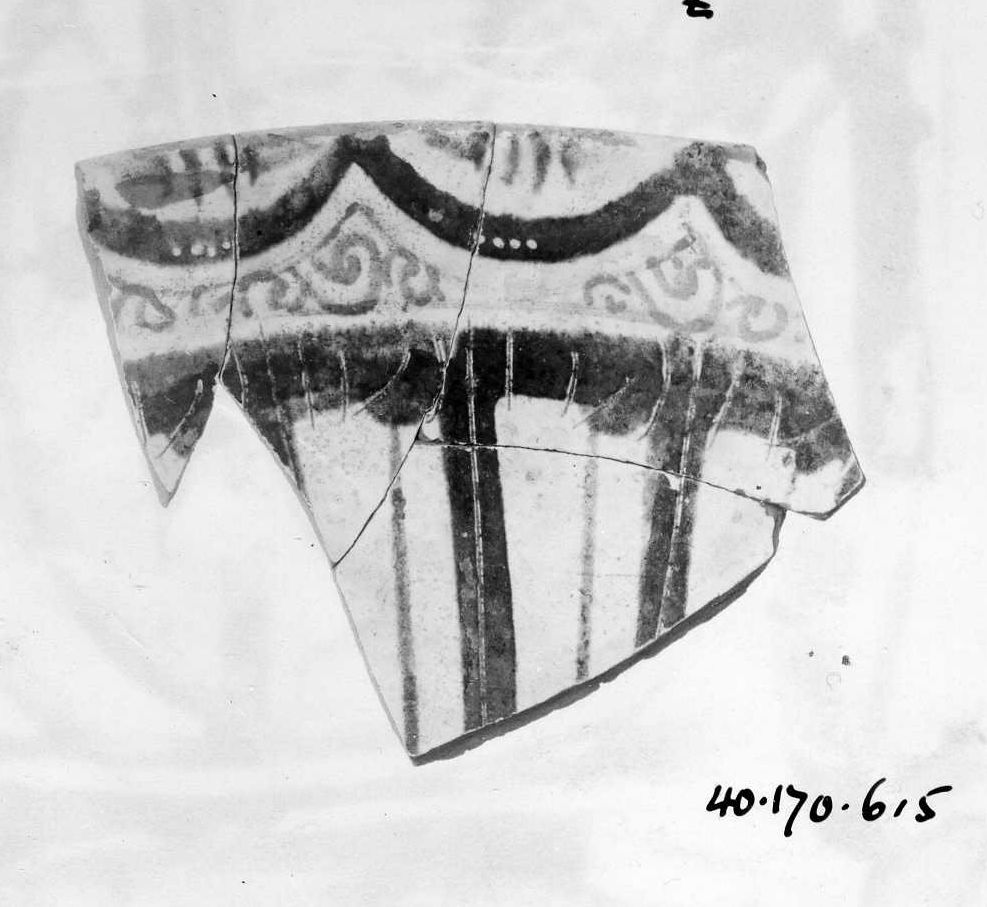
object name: fragment of a bowl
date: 801-1000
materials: earthenware, glaze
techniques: polychrome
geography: iran